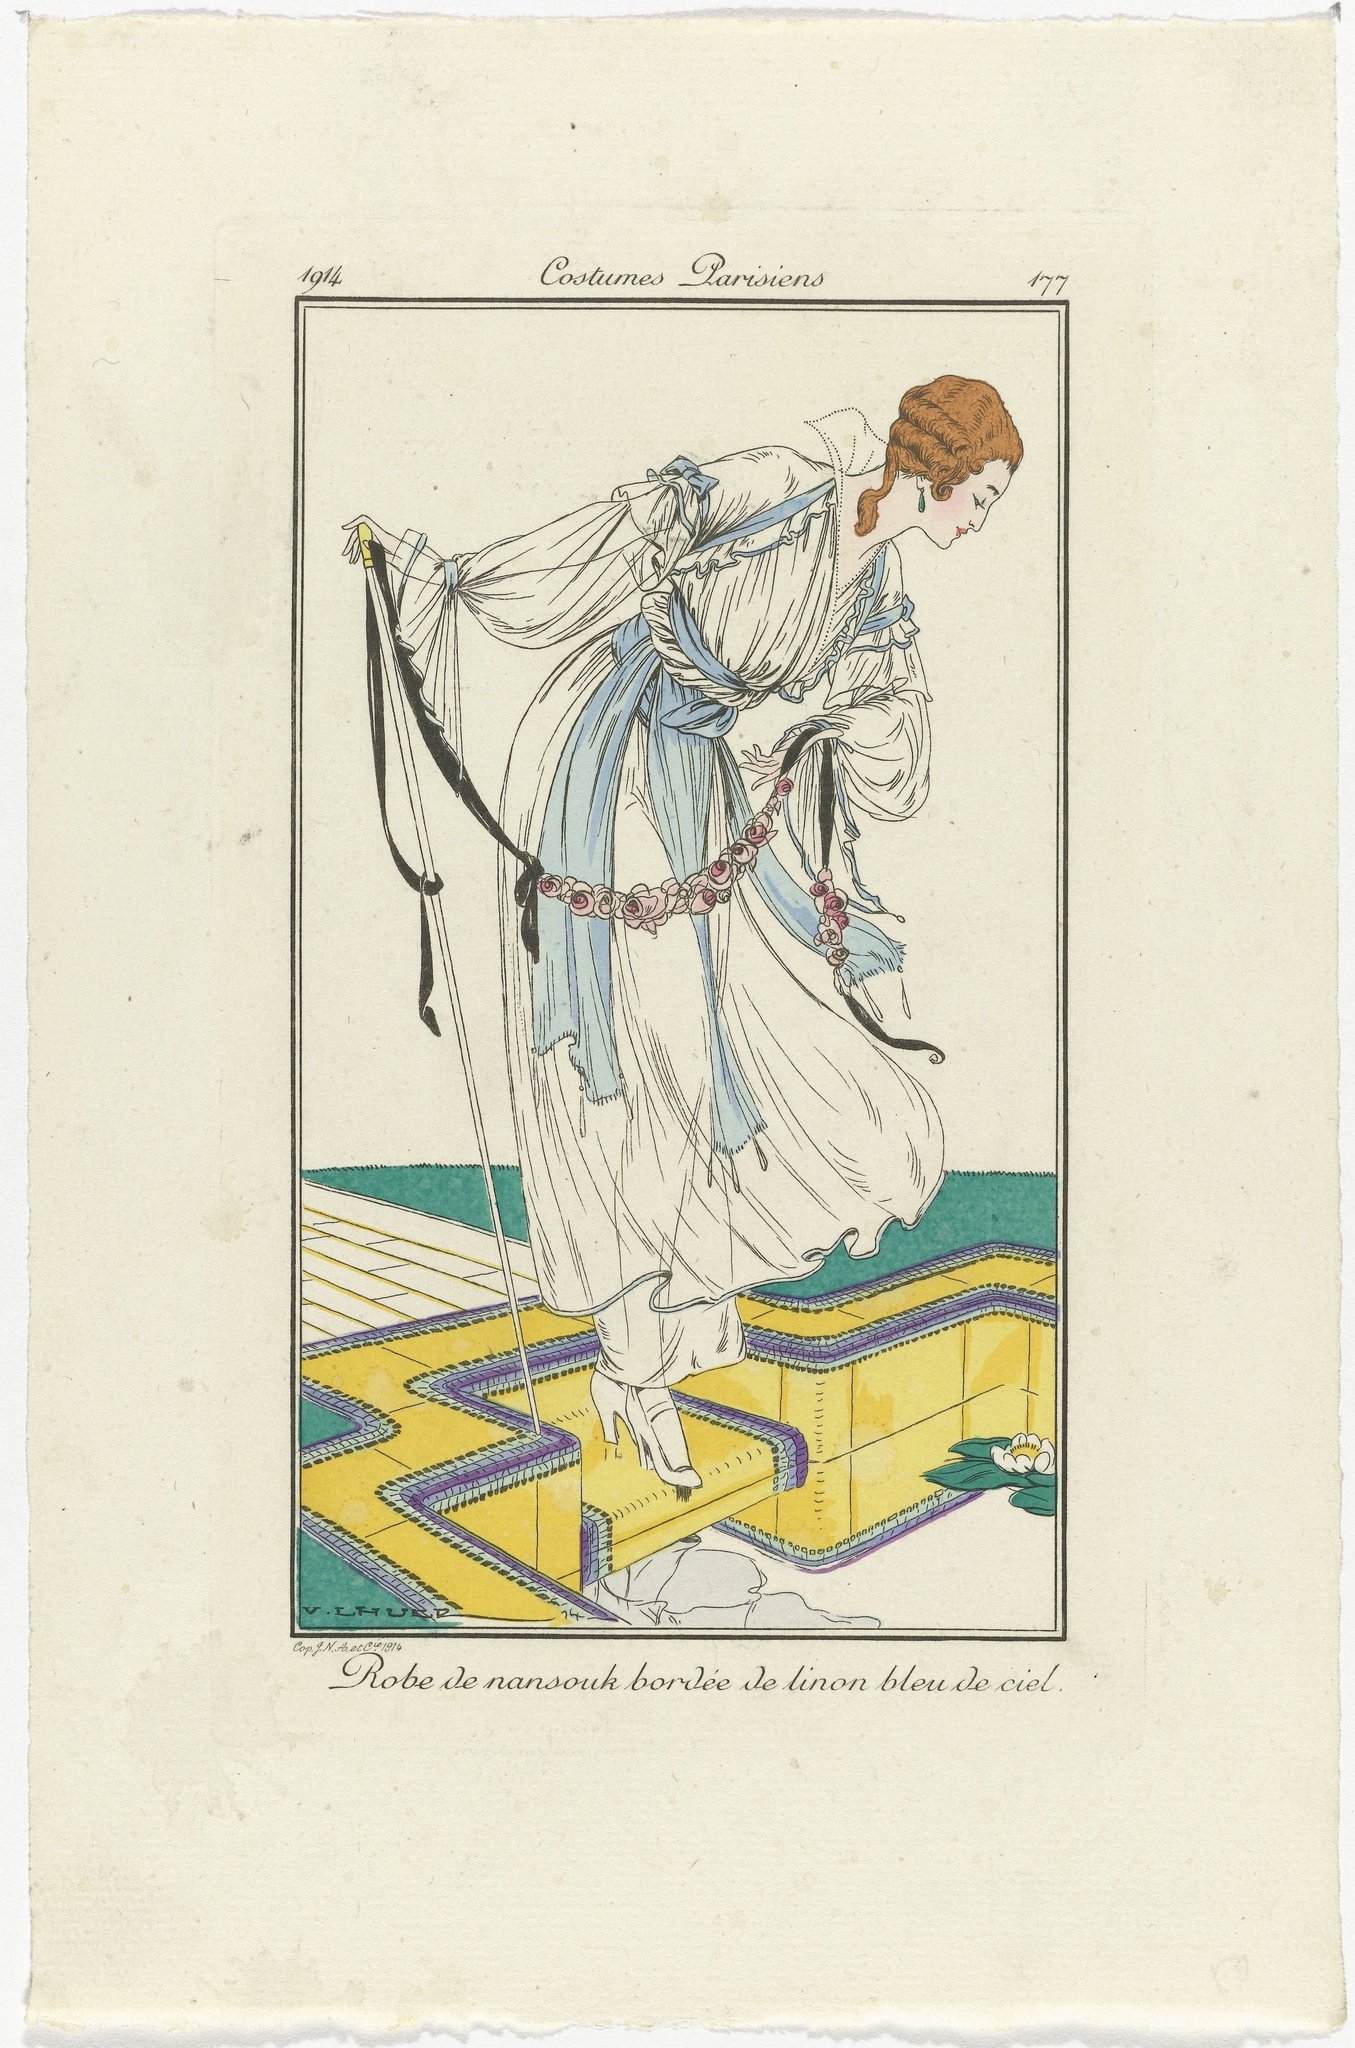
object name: fashion print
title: Journal des Dames et des Modes, Costumes Parisiens, 1914, No. 177 : Robe de nansouk (...)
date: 1914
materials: paper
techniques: engraving, hand coloring, pochoir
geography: paris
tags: flowers, walking-stick, staff, cane (+ women's clothes), fashion plates, dress, gown (+ women's clothes), garden pond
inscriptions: caption: ‘Robe de nansouk bordée de linon bleu de ciel.’, title: ‘Costumes Parisiens’, inscription: ‘Cop. J. N. A. et Cie 1914’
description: Vrouw, staande bij een vijver, in een japon van 'nansouk', afgezet met hemelsblauw linnen. Wandelstok. In de handen een guirlande van bloemen en lint. Prent uit het modetijdschrift Journal des Dames et des Modes (1912-1914).